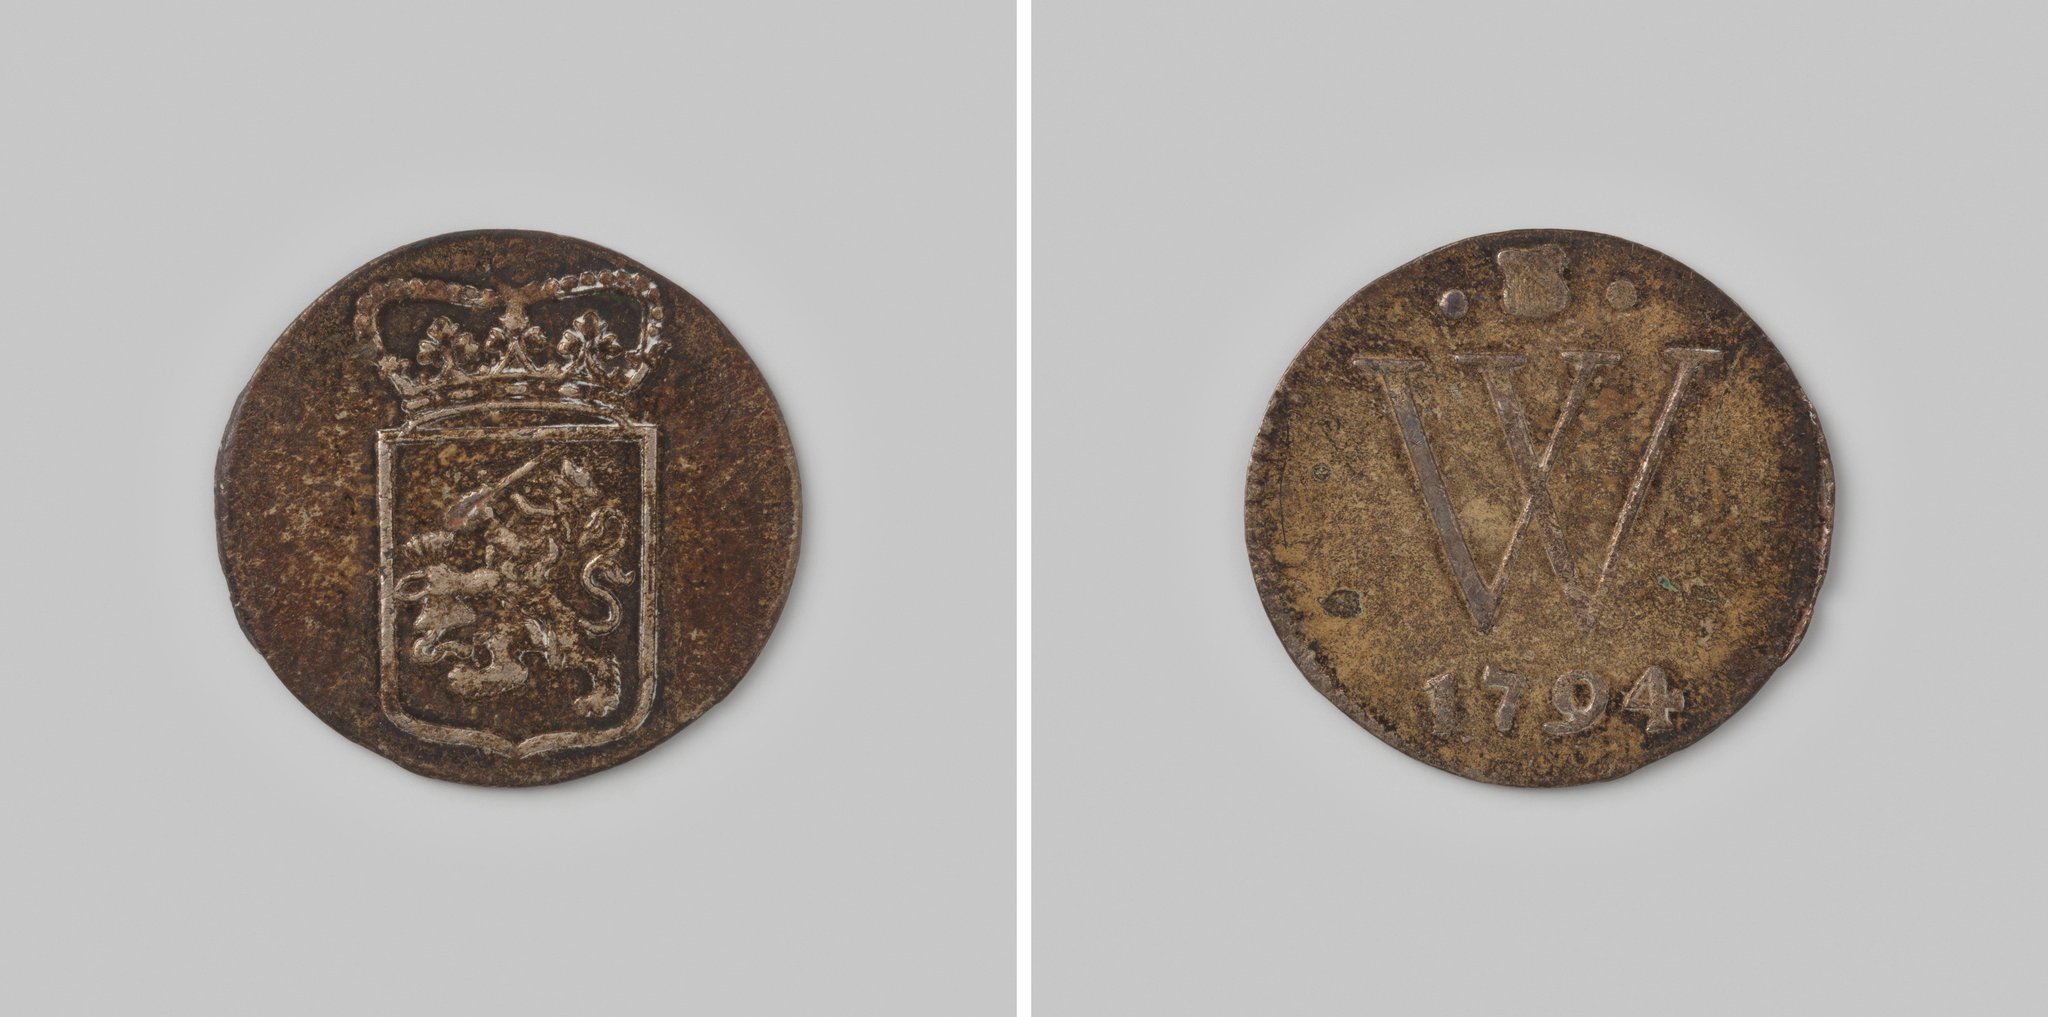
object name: coin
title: 2 stuiver van West-Indië, 1794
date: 1794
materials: silver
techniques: striking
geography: utrecht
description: Zilveren munt. Voorzijde: gekroond generaliteitswapenschild. Keerzijde: letter W [=West-Indië]. Daarboven wapenschild van de stad Utrecht en daaronder jaartal.